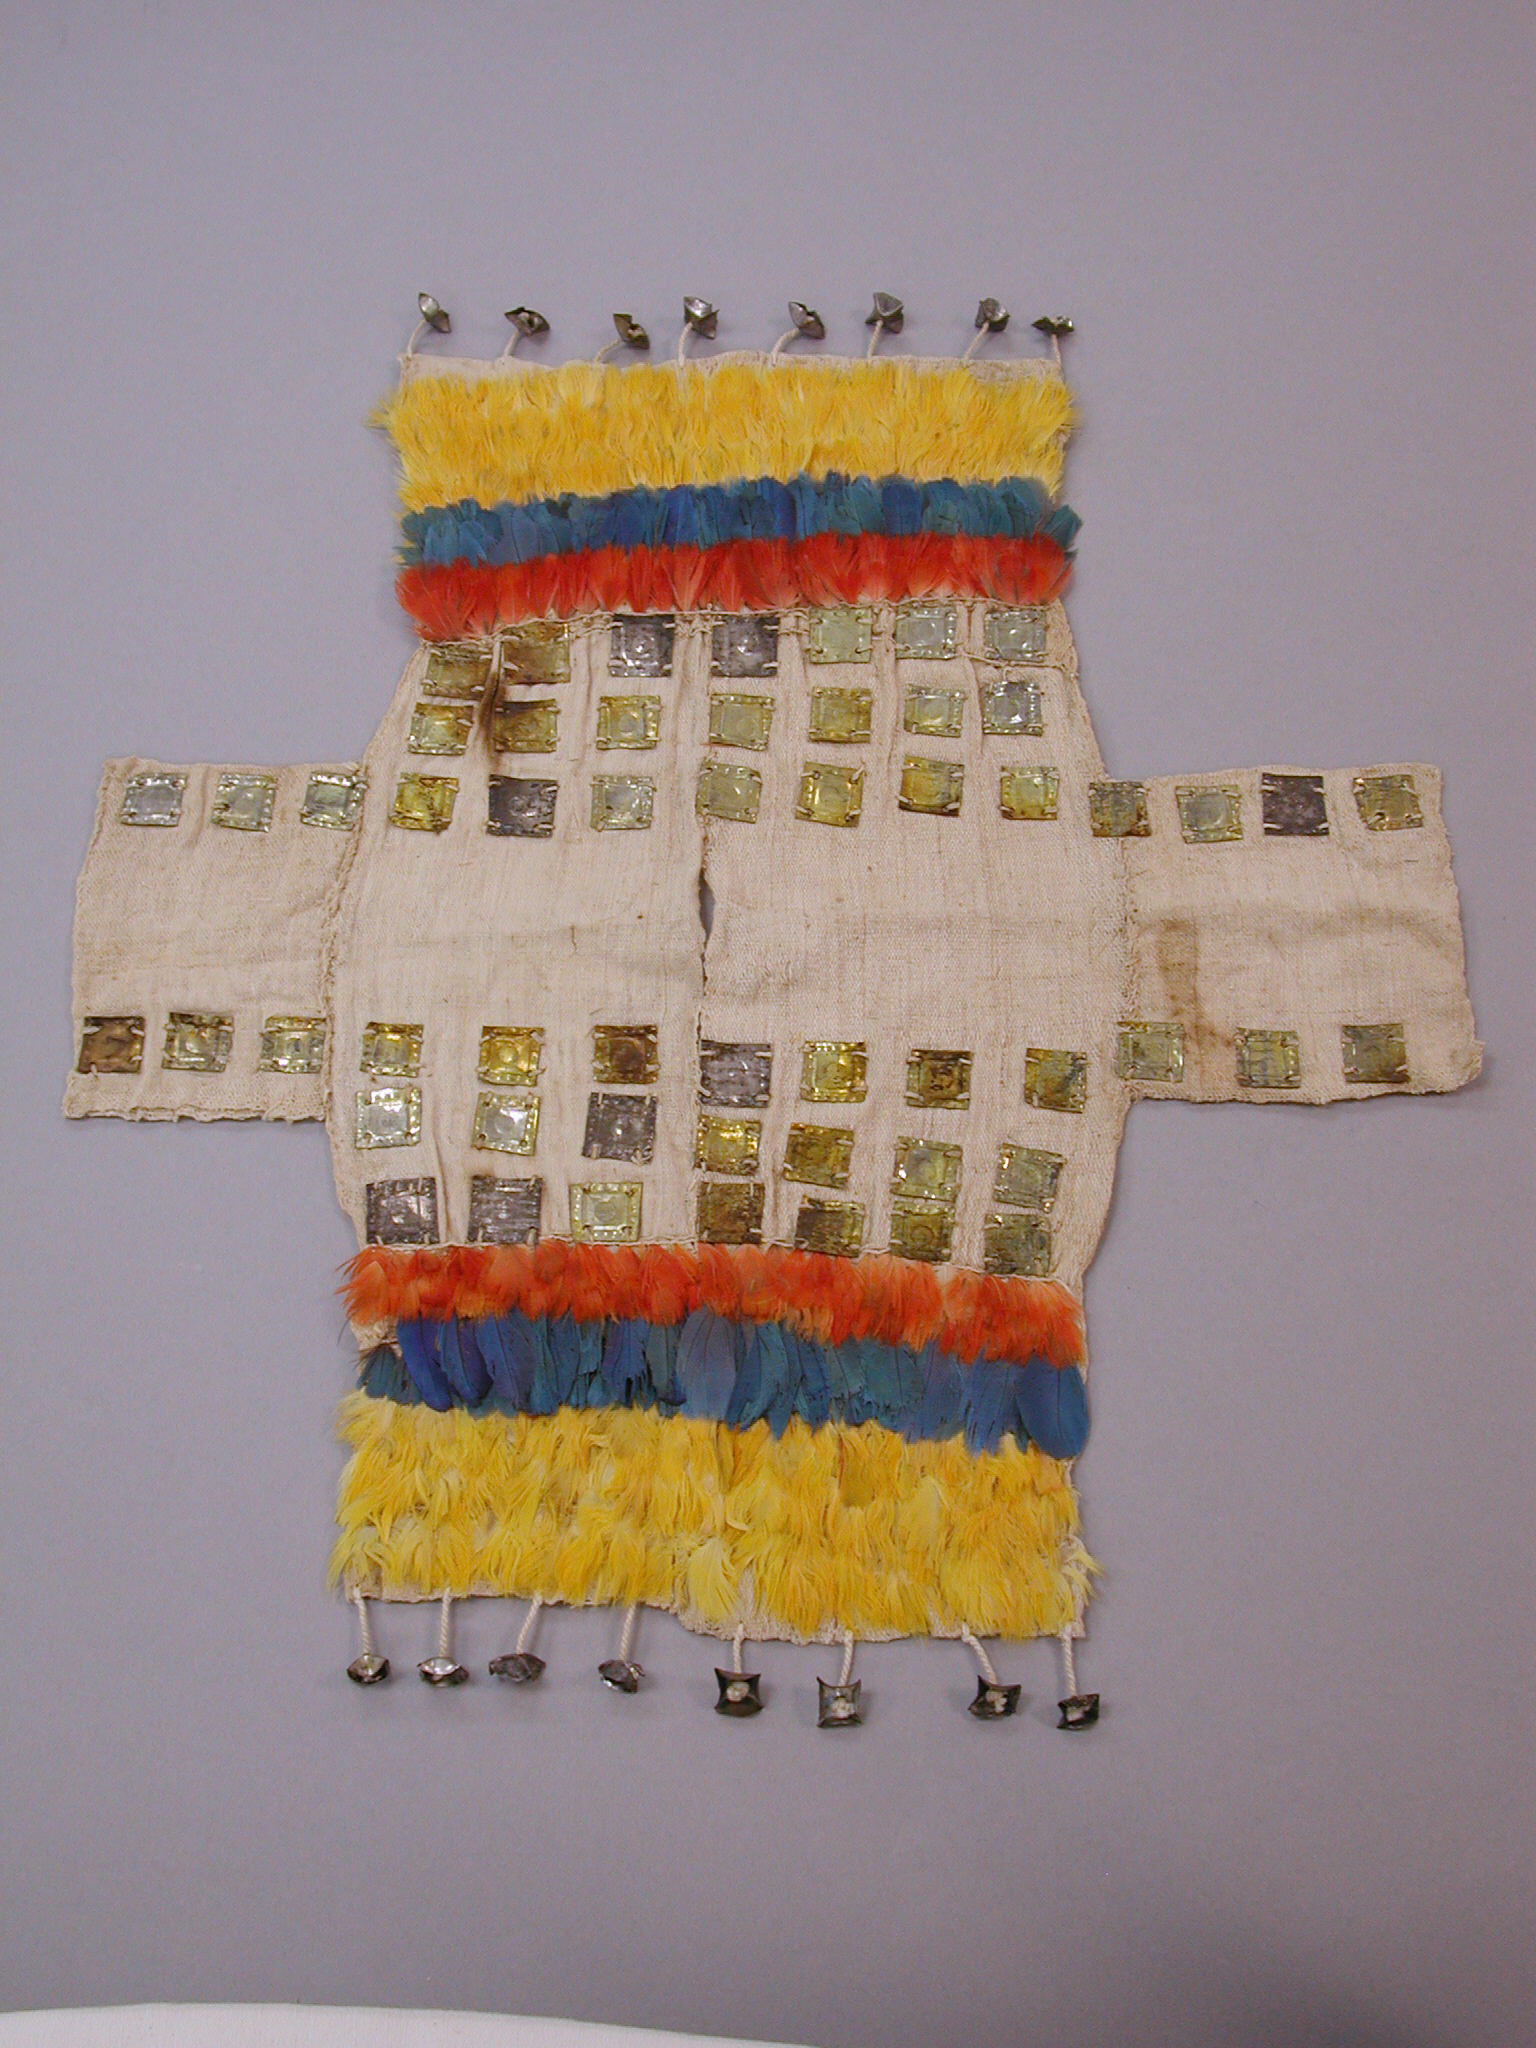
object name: shirt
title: Feathered Shirt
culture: chimú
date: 1201-1500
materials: cotton, feather, silver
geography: peru